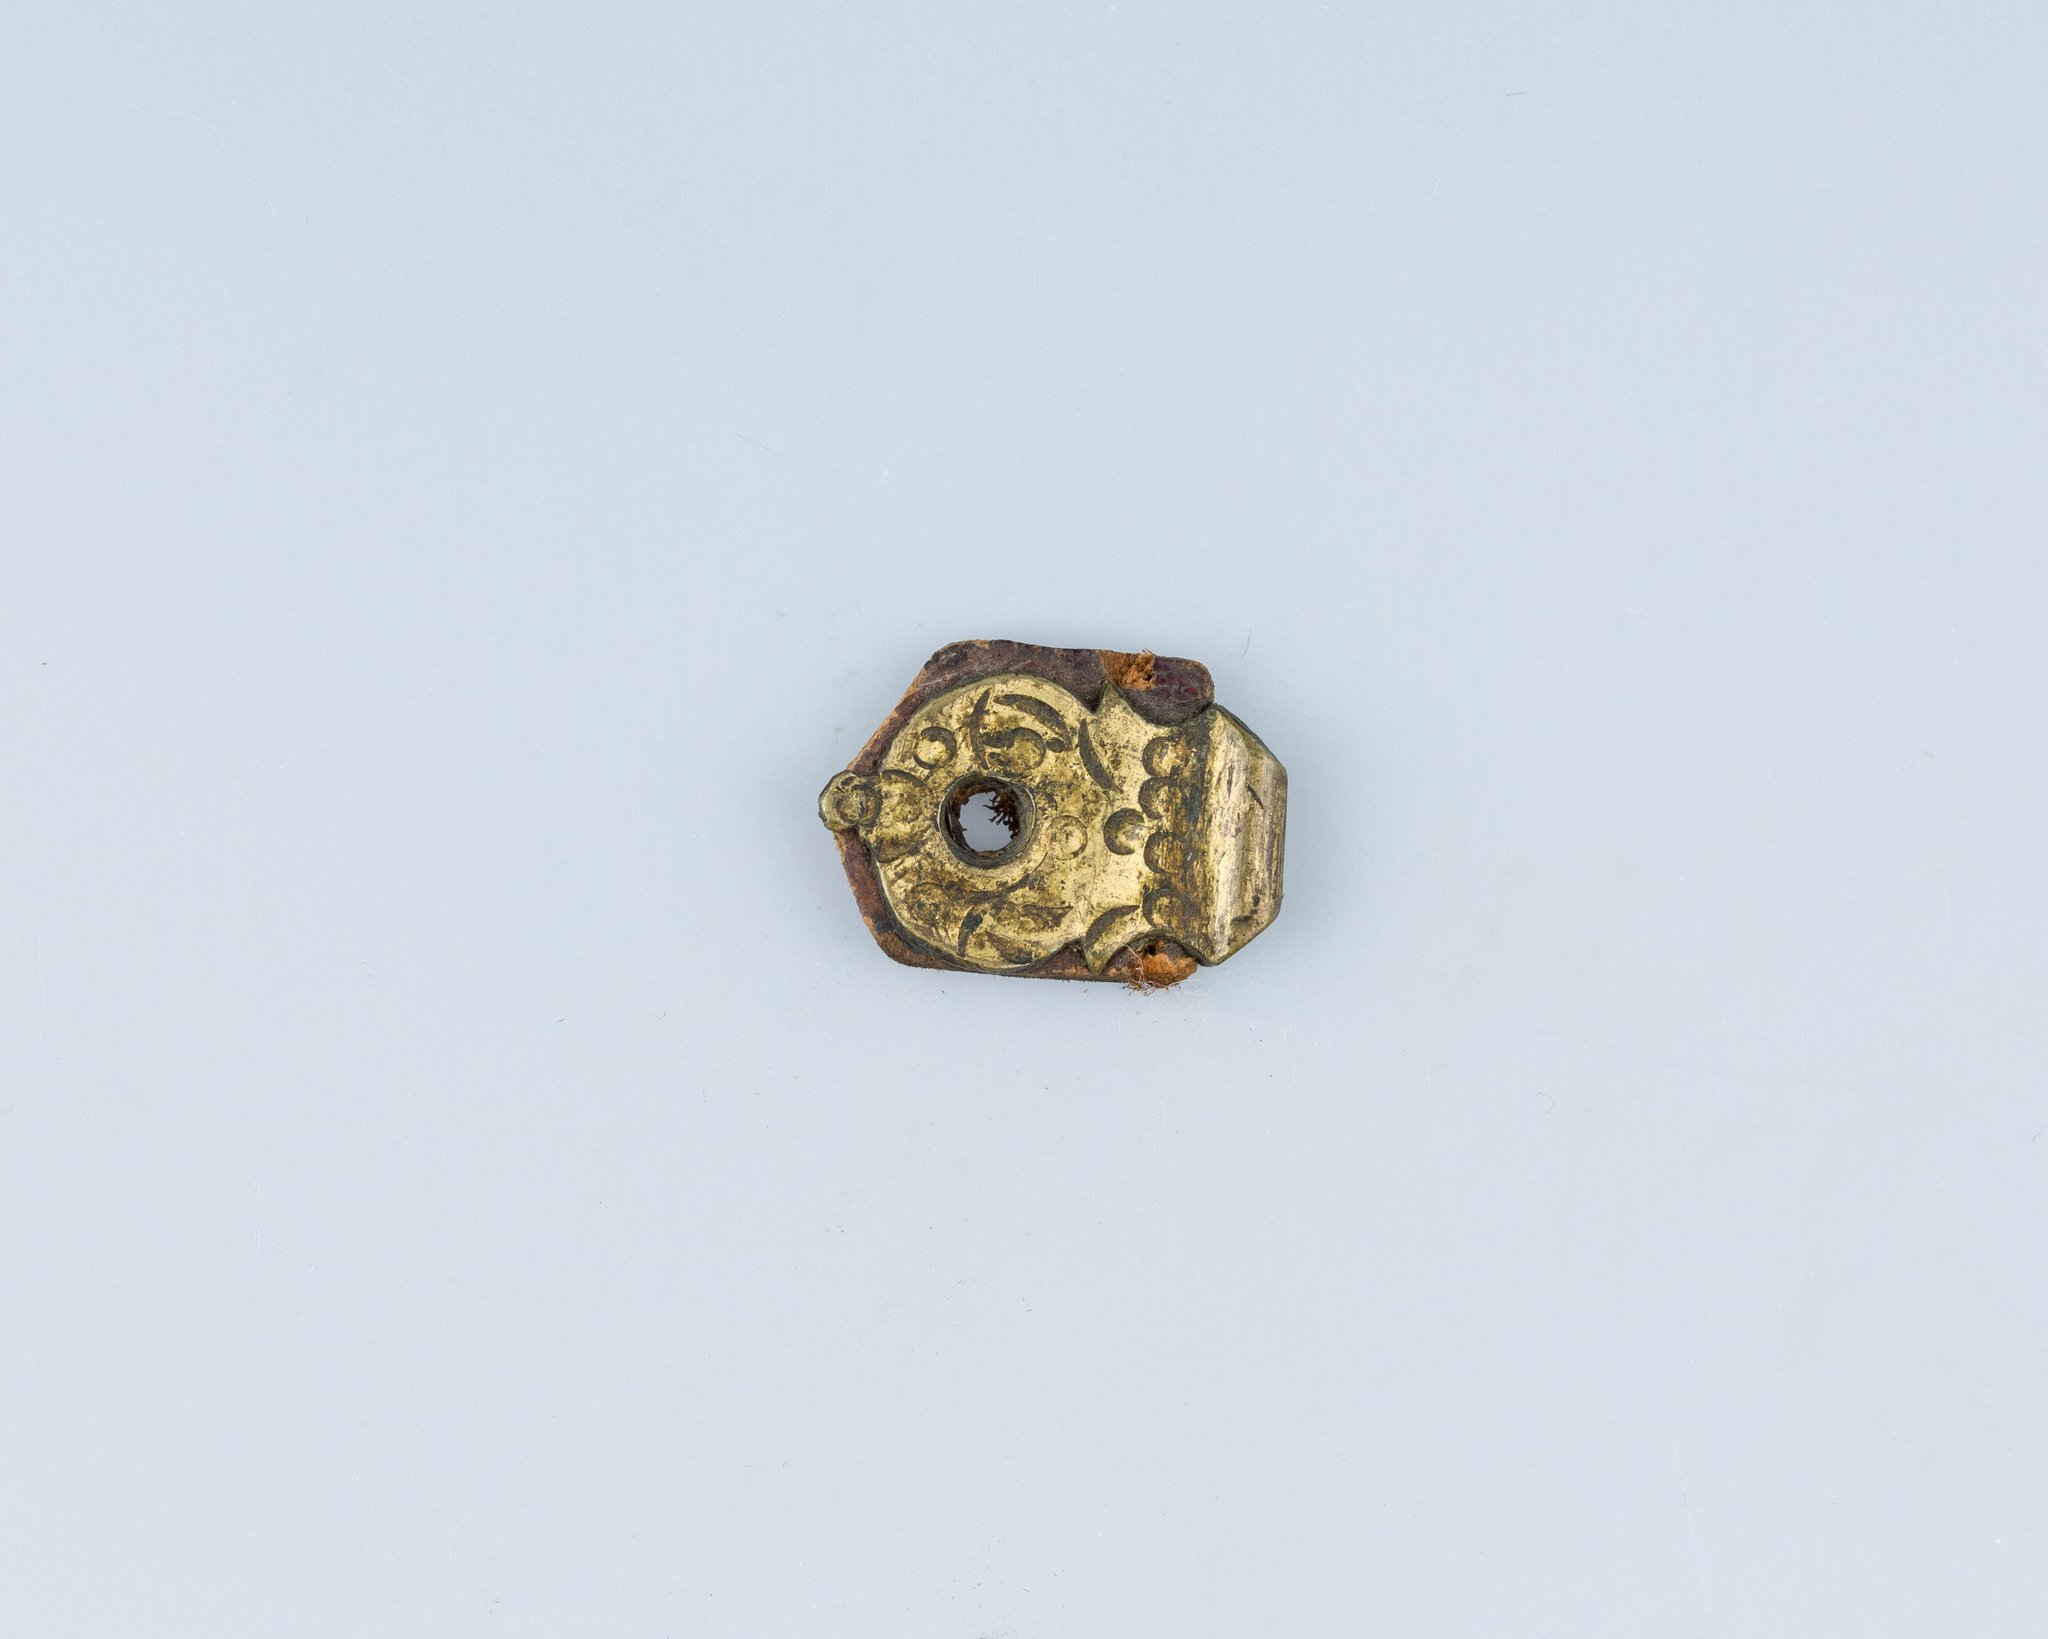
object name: mordant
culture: german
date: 1600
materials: brass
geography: germany